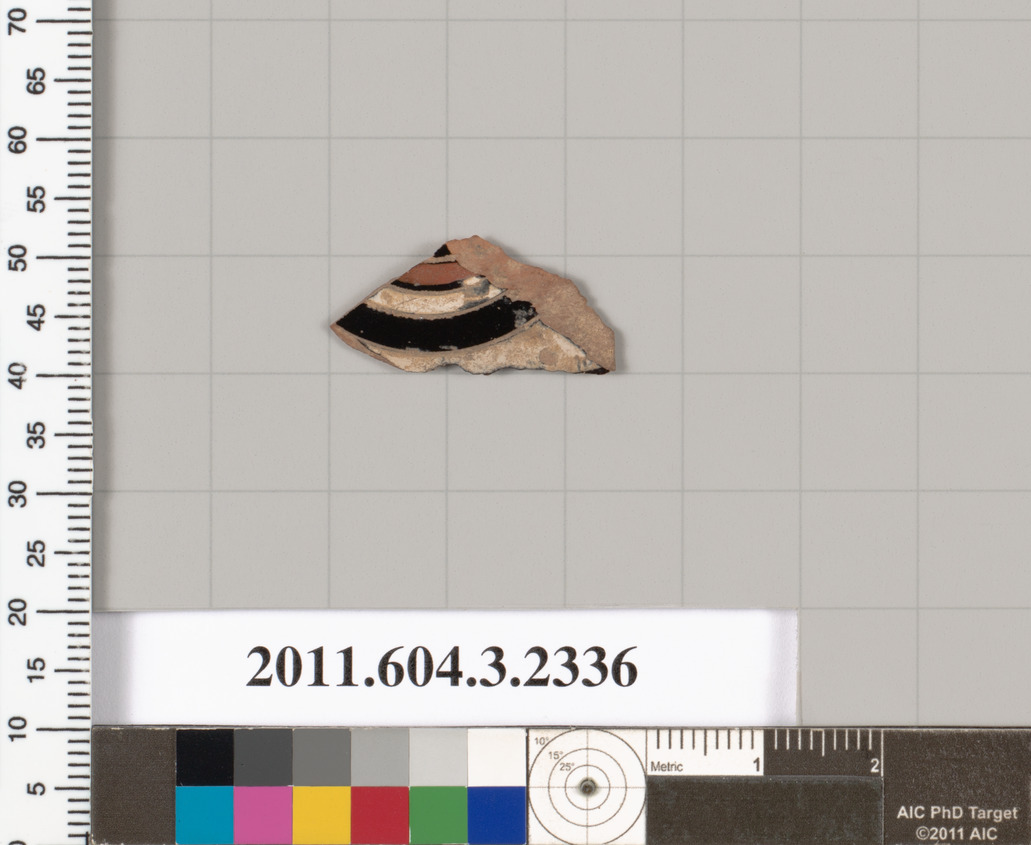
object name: kylix fragment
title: Terracotta fragment of a kylix: eye-cup (drinking cup)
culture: greek, attic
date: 540-520 BCE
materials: terracotta